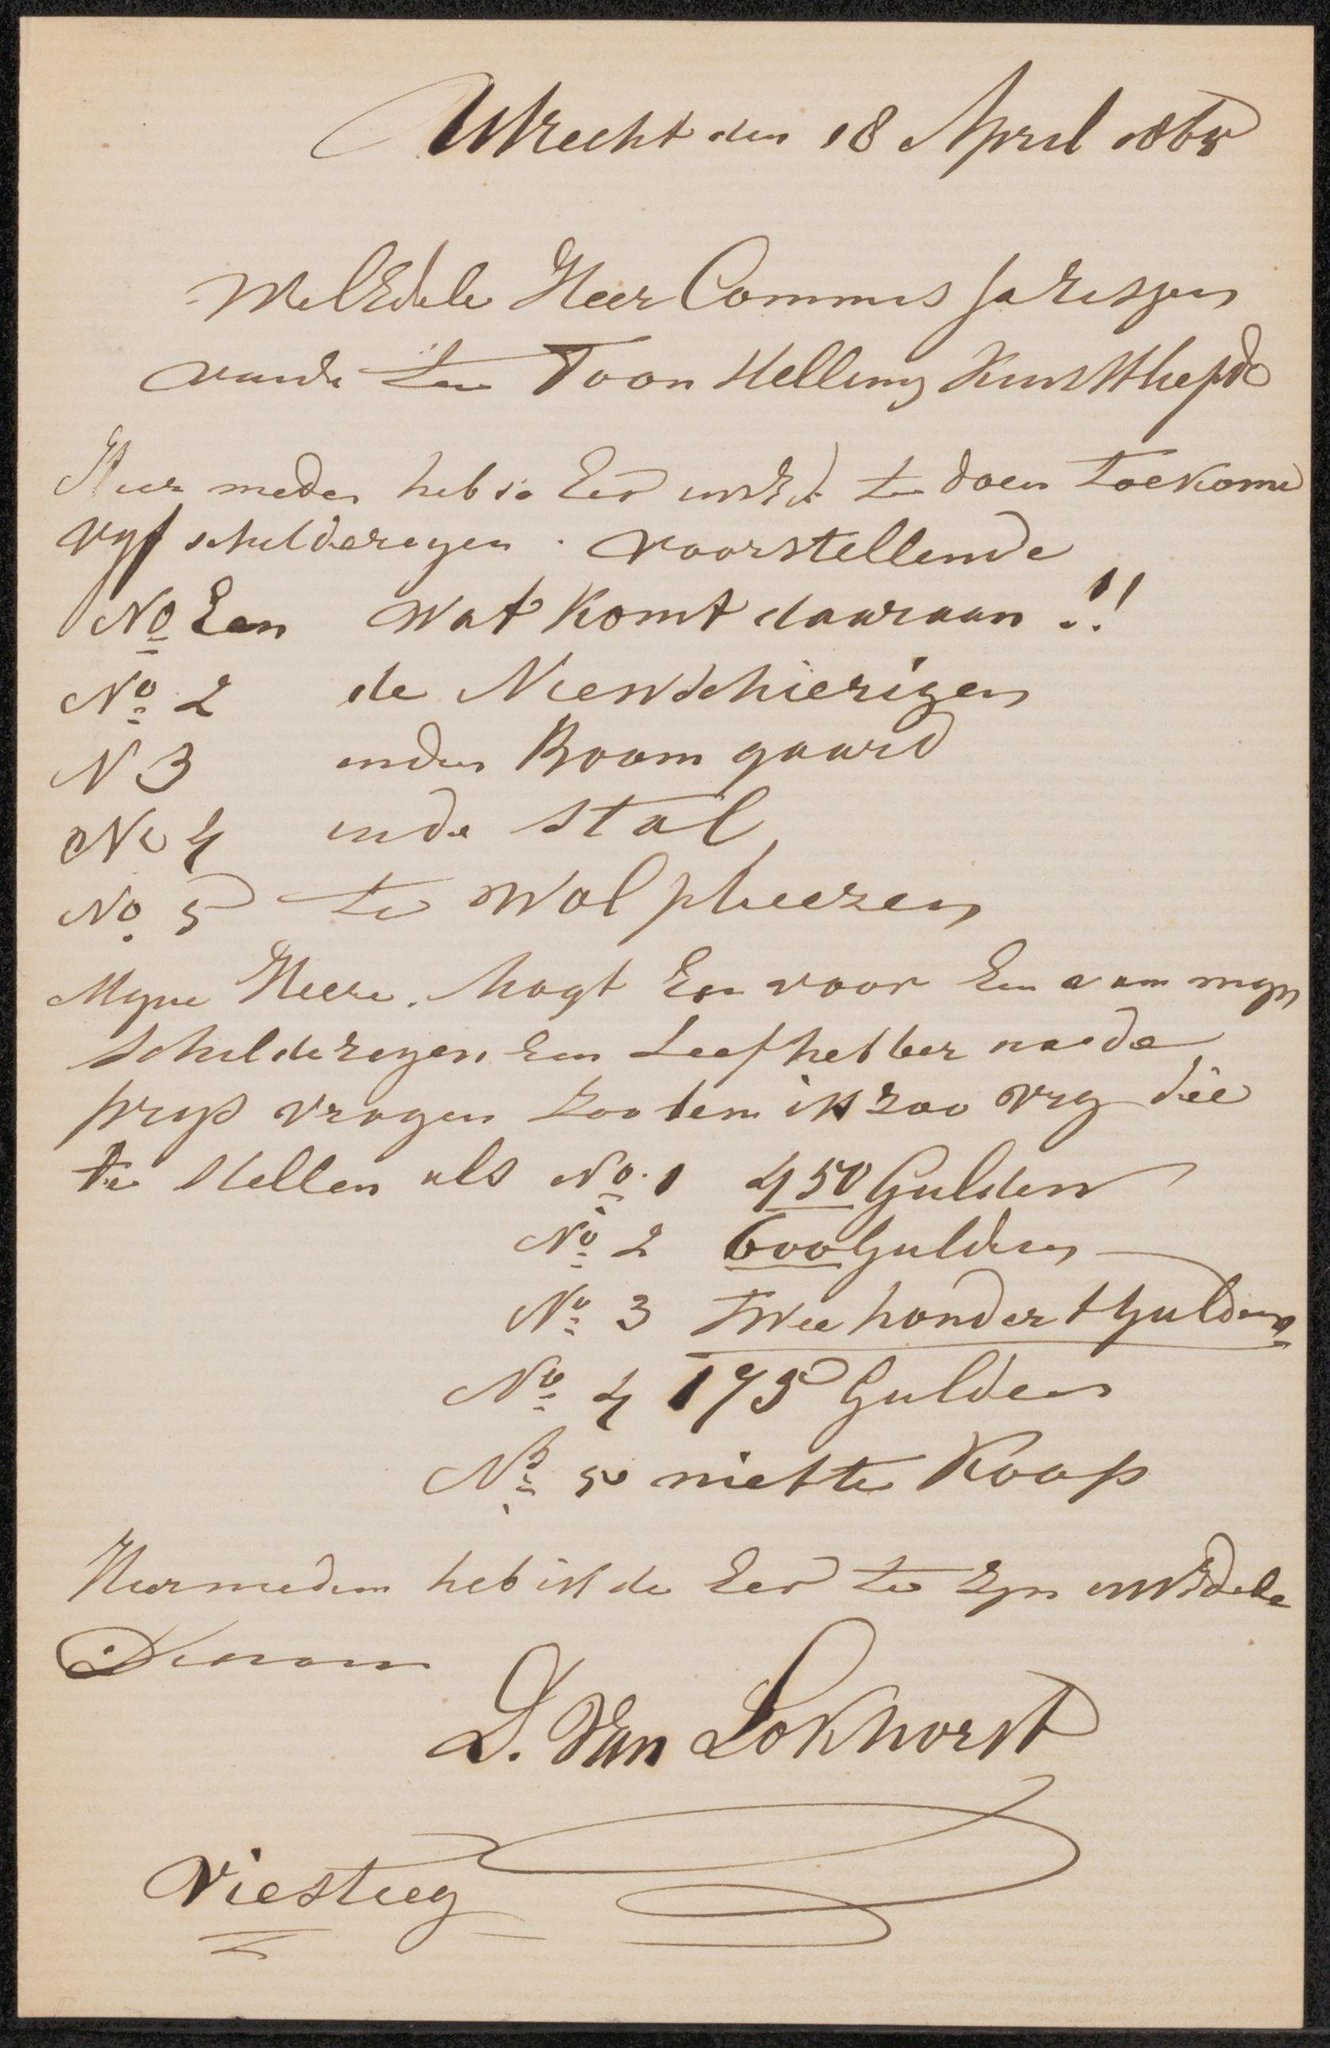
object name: letter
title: Brief aan de commissie van de tentoonstelling gehouden door Genootschap Kunstliefde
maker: dirk van lokhorst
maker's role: draughtsman, painter, print maker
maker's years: 1818-1893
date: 1865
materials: ink, paper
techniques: pen, writing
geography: utrecht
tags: painting (including book-illumination, miniature-painting), exhibition ~ art, money